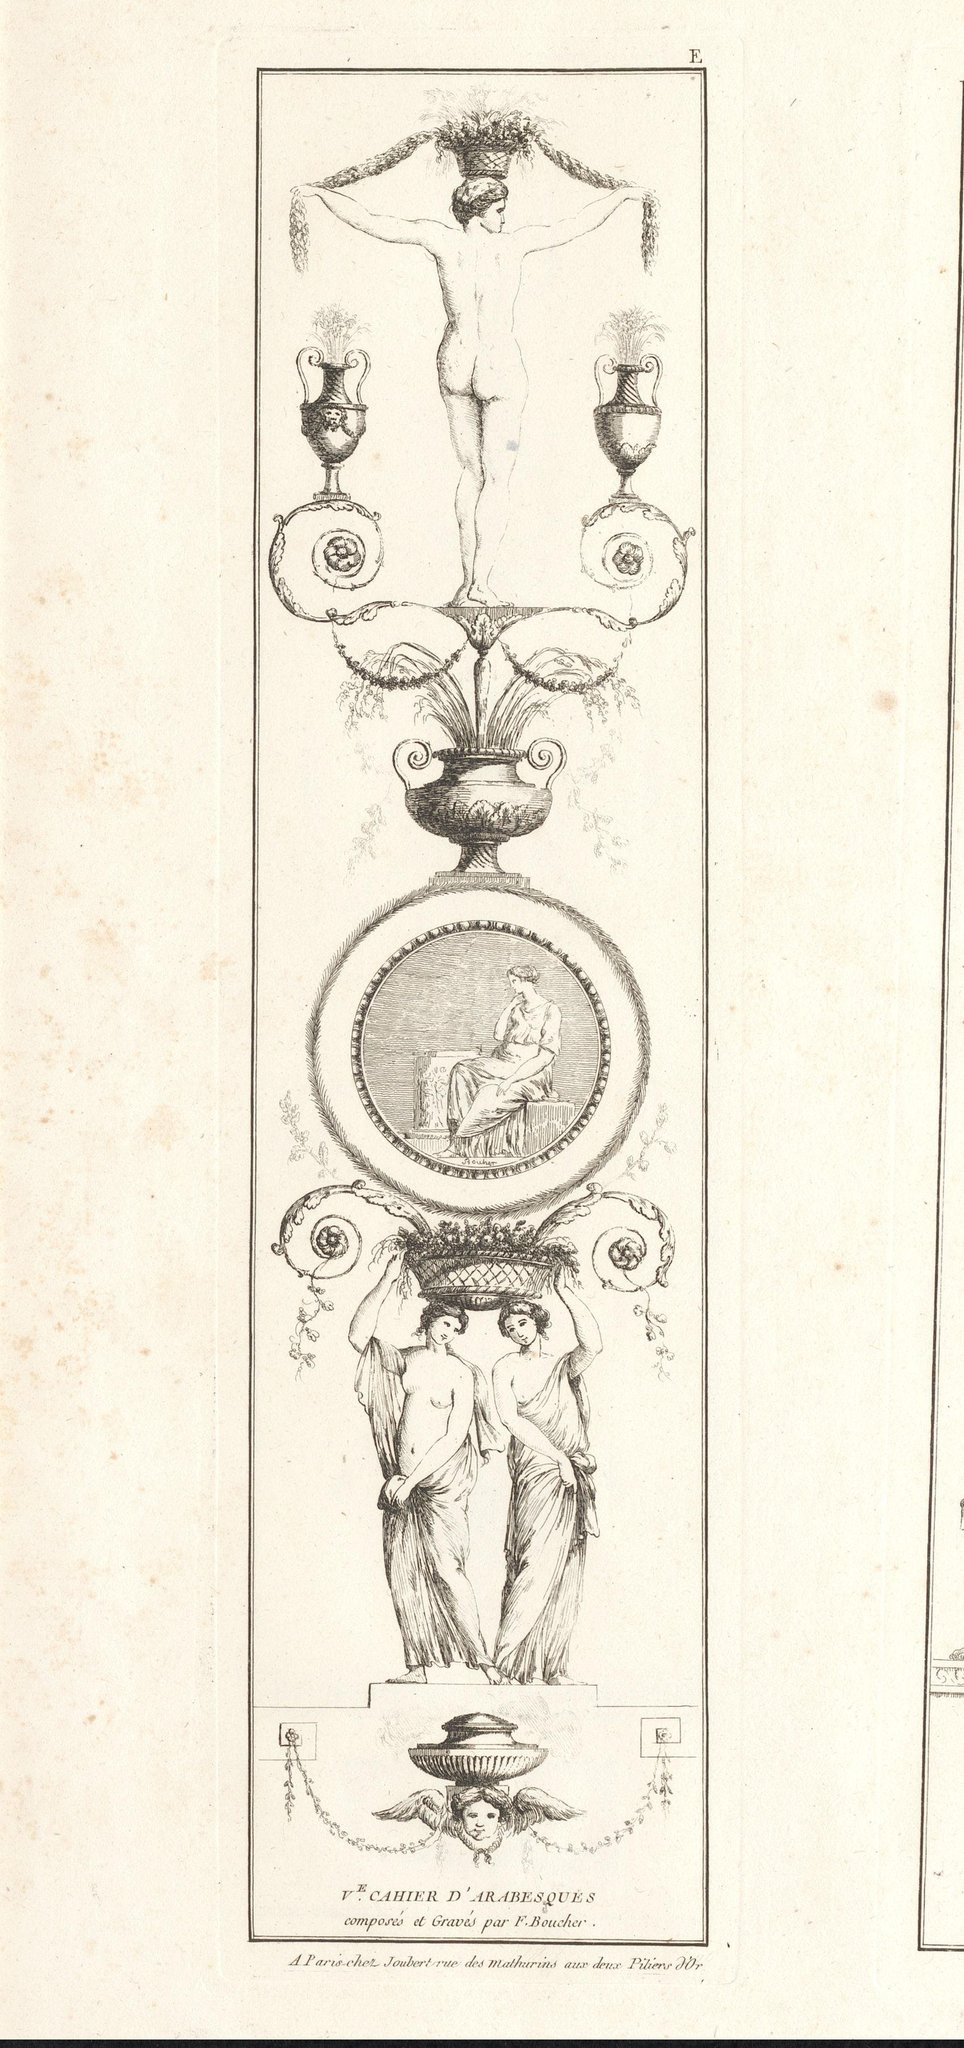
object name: titelprent, frontispice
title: Verzameling van arabesken, met de Vaticaanse loggia's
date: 1802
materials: paper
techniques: etching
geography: paris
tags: (showing oneself) undressed, quasi-nude, ornament ~ arabesque, garland, wreath, vase ~ ornament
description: Doordat dit album bestaat uit meerdere, deels eerder uitgegeven prentreeksen, is de datering niet consequent. Het geheel is op de titelpagina gedateerd op 1802. Deze reeks is niet los gedateerd. De serietitel voor het gehele werk is "Recueil d'arabesques, contenant les loges du Vatican". De andere serietitel is de titel van de specifieke reeks binnen het geheel.